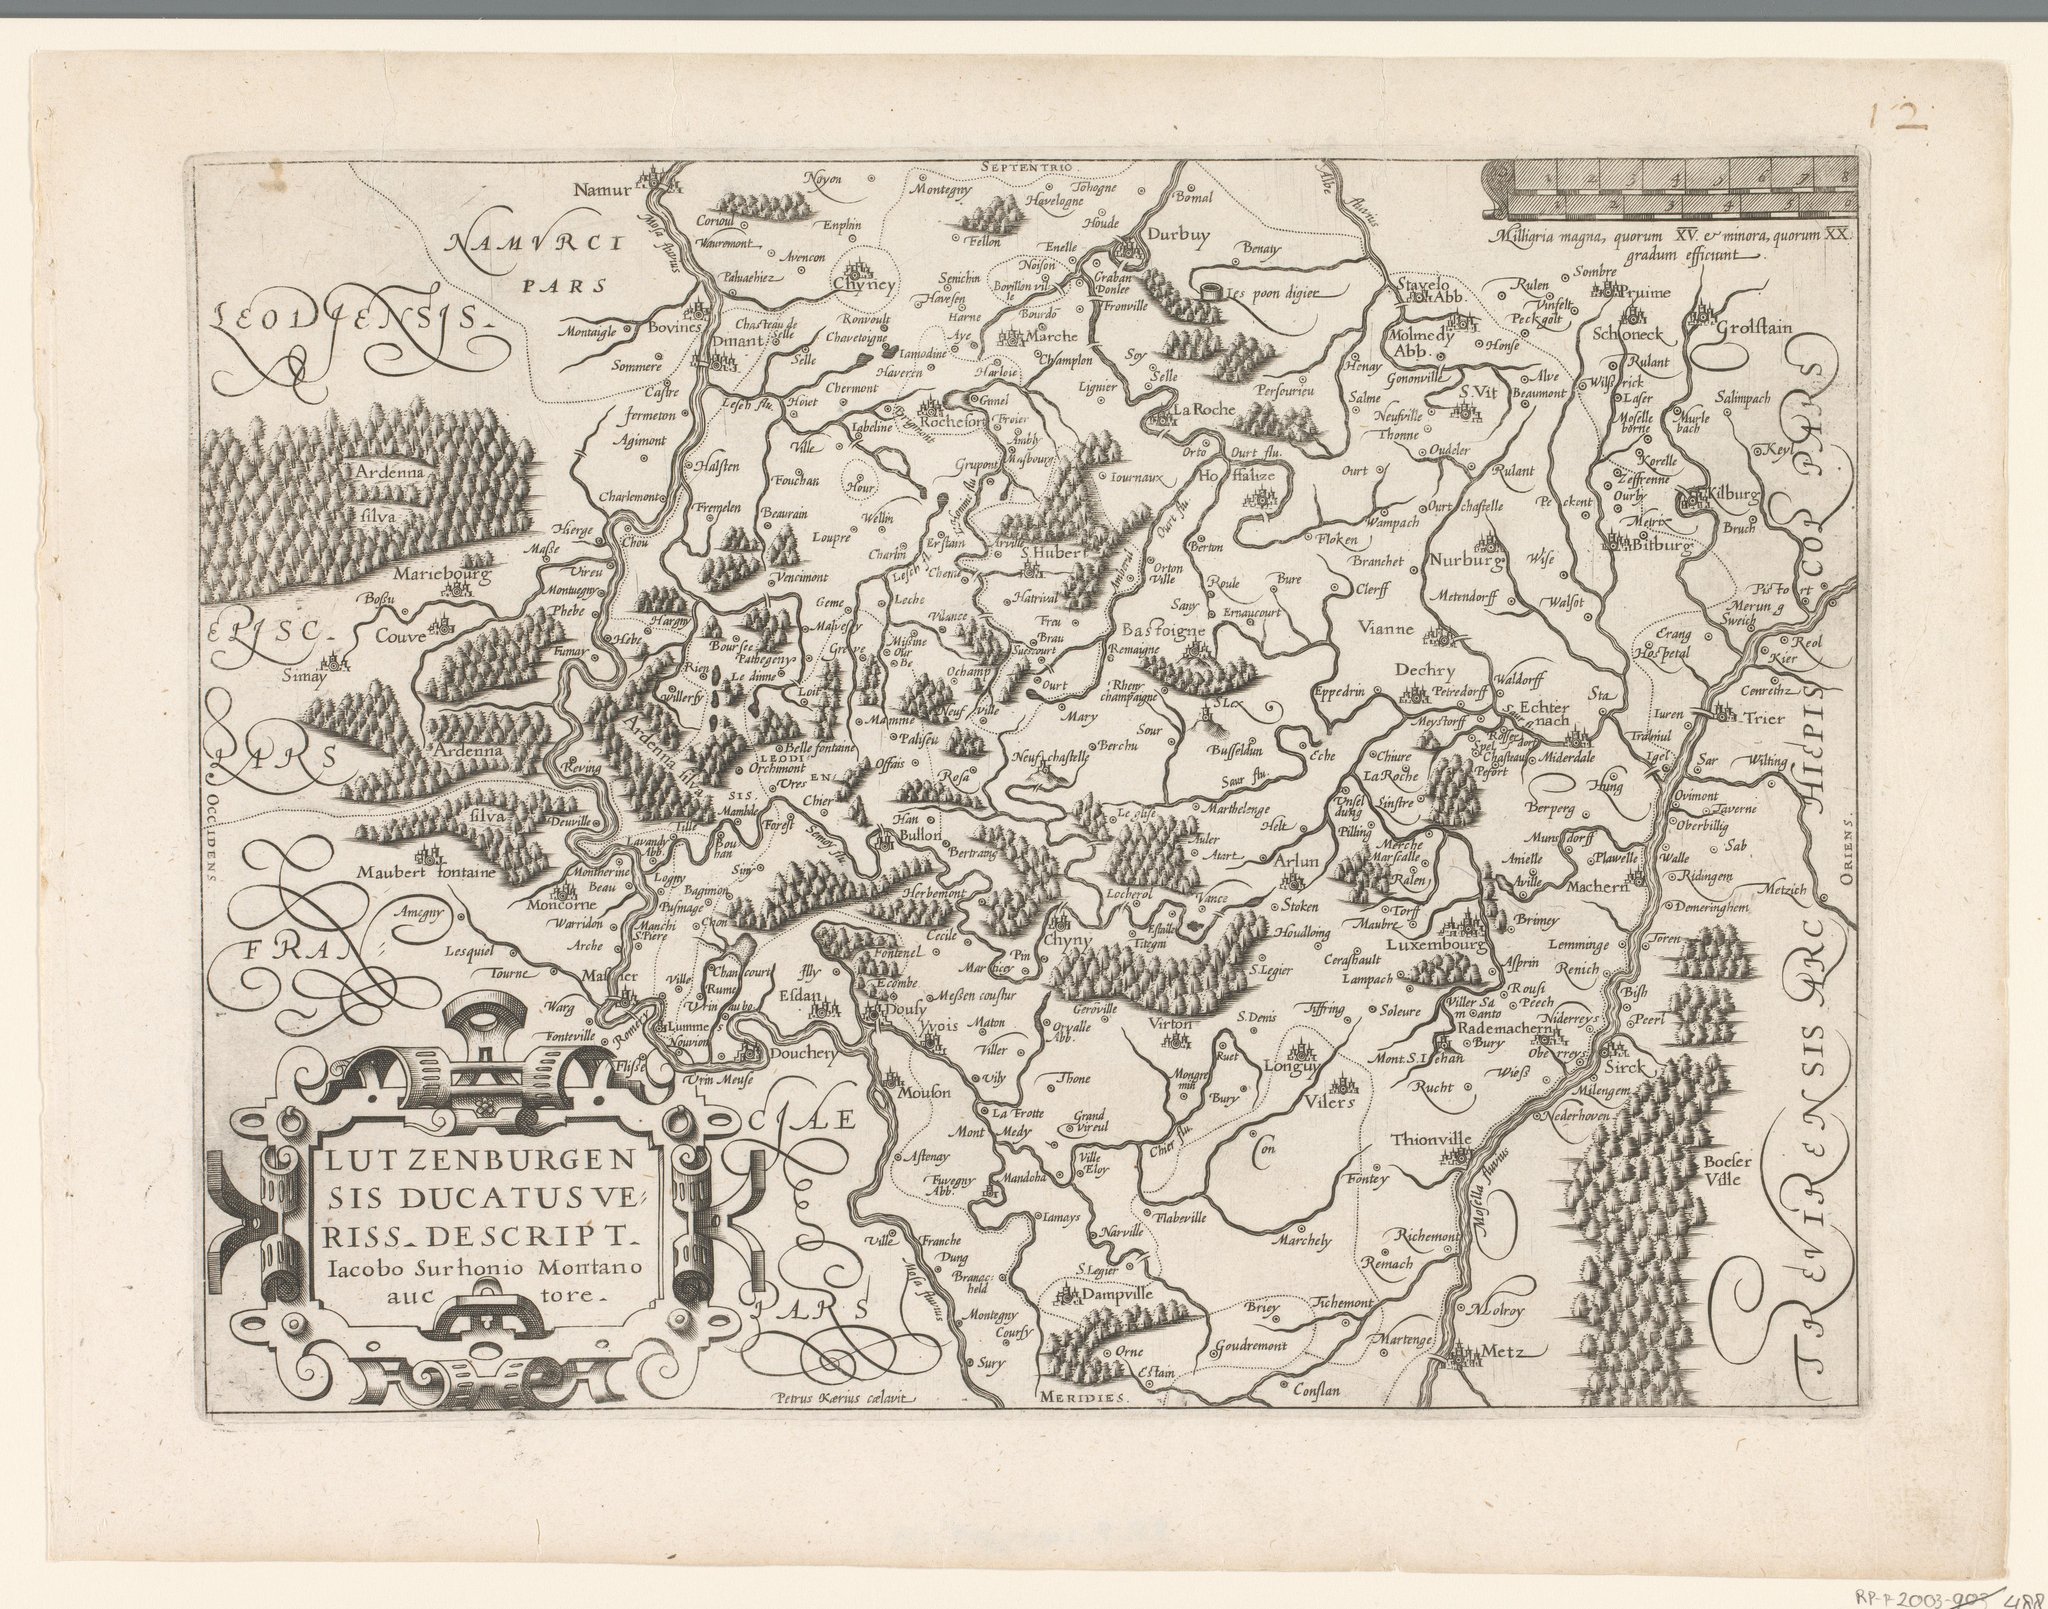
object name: map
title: Kaart van het hertogdom Luxemburg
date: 1607-1609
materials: paper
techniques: engraving, etching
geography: southern netherlands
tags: maps of separate countries or regions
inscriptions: number: ‘12’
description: Kaart van het hertogdom Luxemburg (Luxembourg). Linksonder een cartouche met de titel, rechtsboven twee schaalstokken. Onderdeel van de verzameling kaarten genomen uit een latere editie van: Descrittione di tutti i Paesi Bassi van Lodovico Guicciardini.